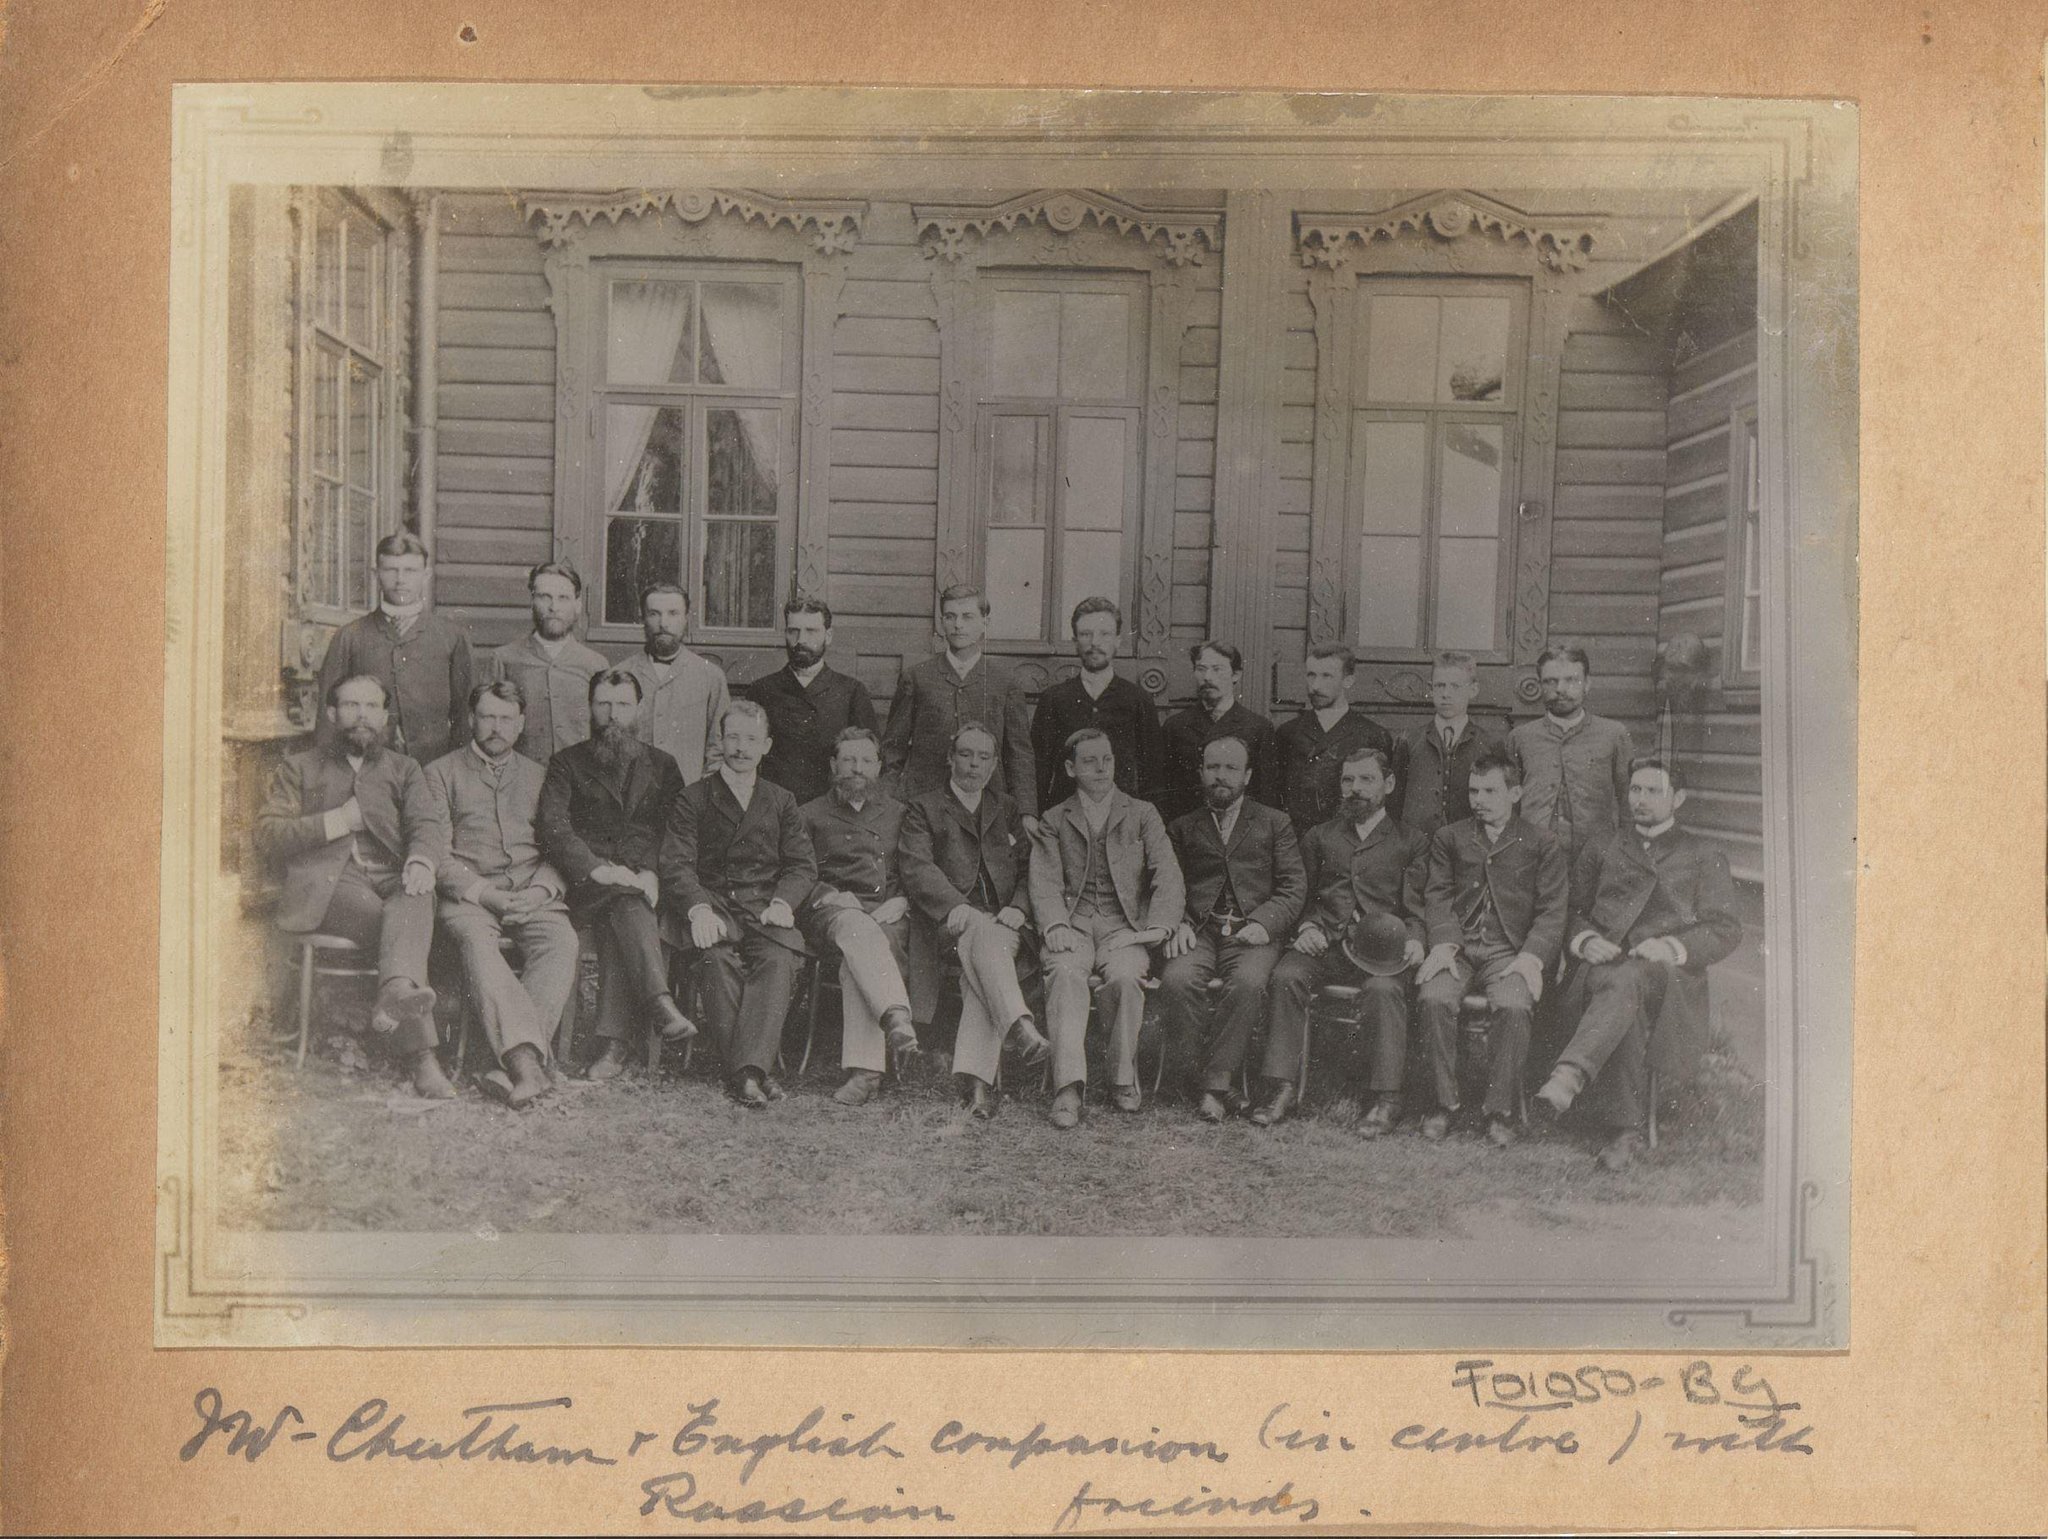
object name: reproduction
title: Fotoreproductie van een foto voorstellend een groepsportret van Joseph Cheetham (vooraan, midden) samen met Engelse en Russische vrienden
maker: joseph cheetham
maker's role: engineer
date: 1903-1904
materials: photographic support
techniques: gelatin silver print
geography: russia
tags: engineer, joseph cheetham, adult man, russia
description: Onderdeel van Fotoalbum van de Engelse familie Cheetham met opnames van hun verblijf in Rusland.